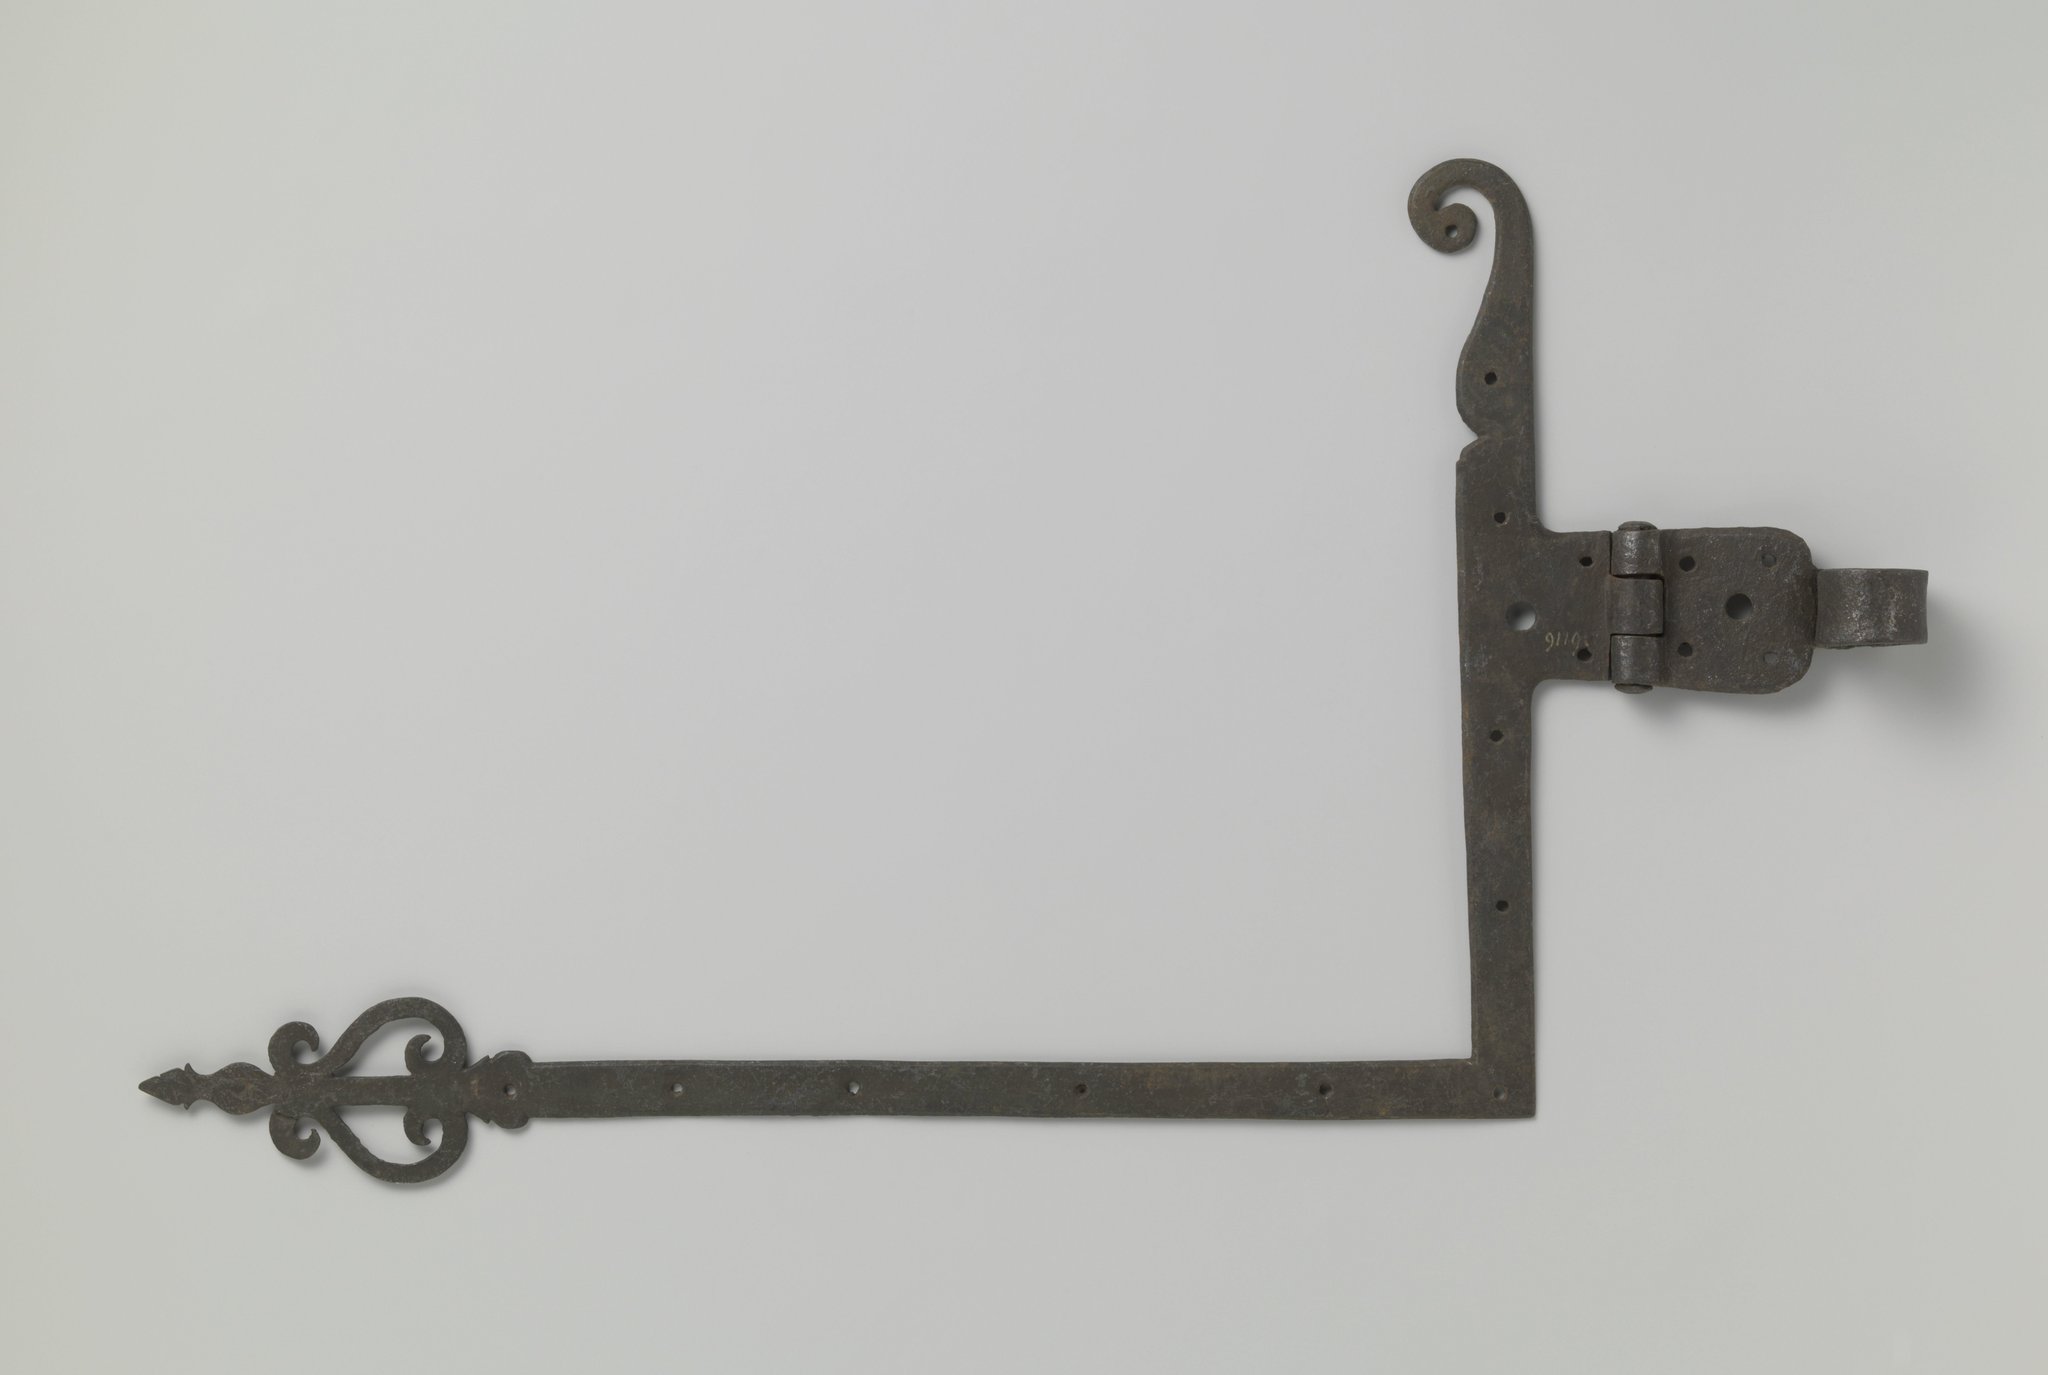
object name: hengsel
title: Hengsel met scharnier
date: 1400-1950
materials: iron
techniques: forging